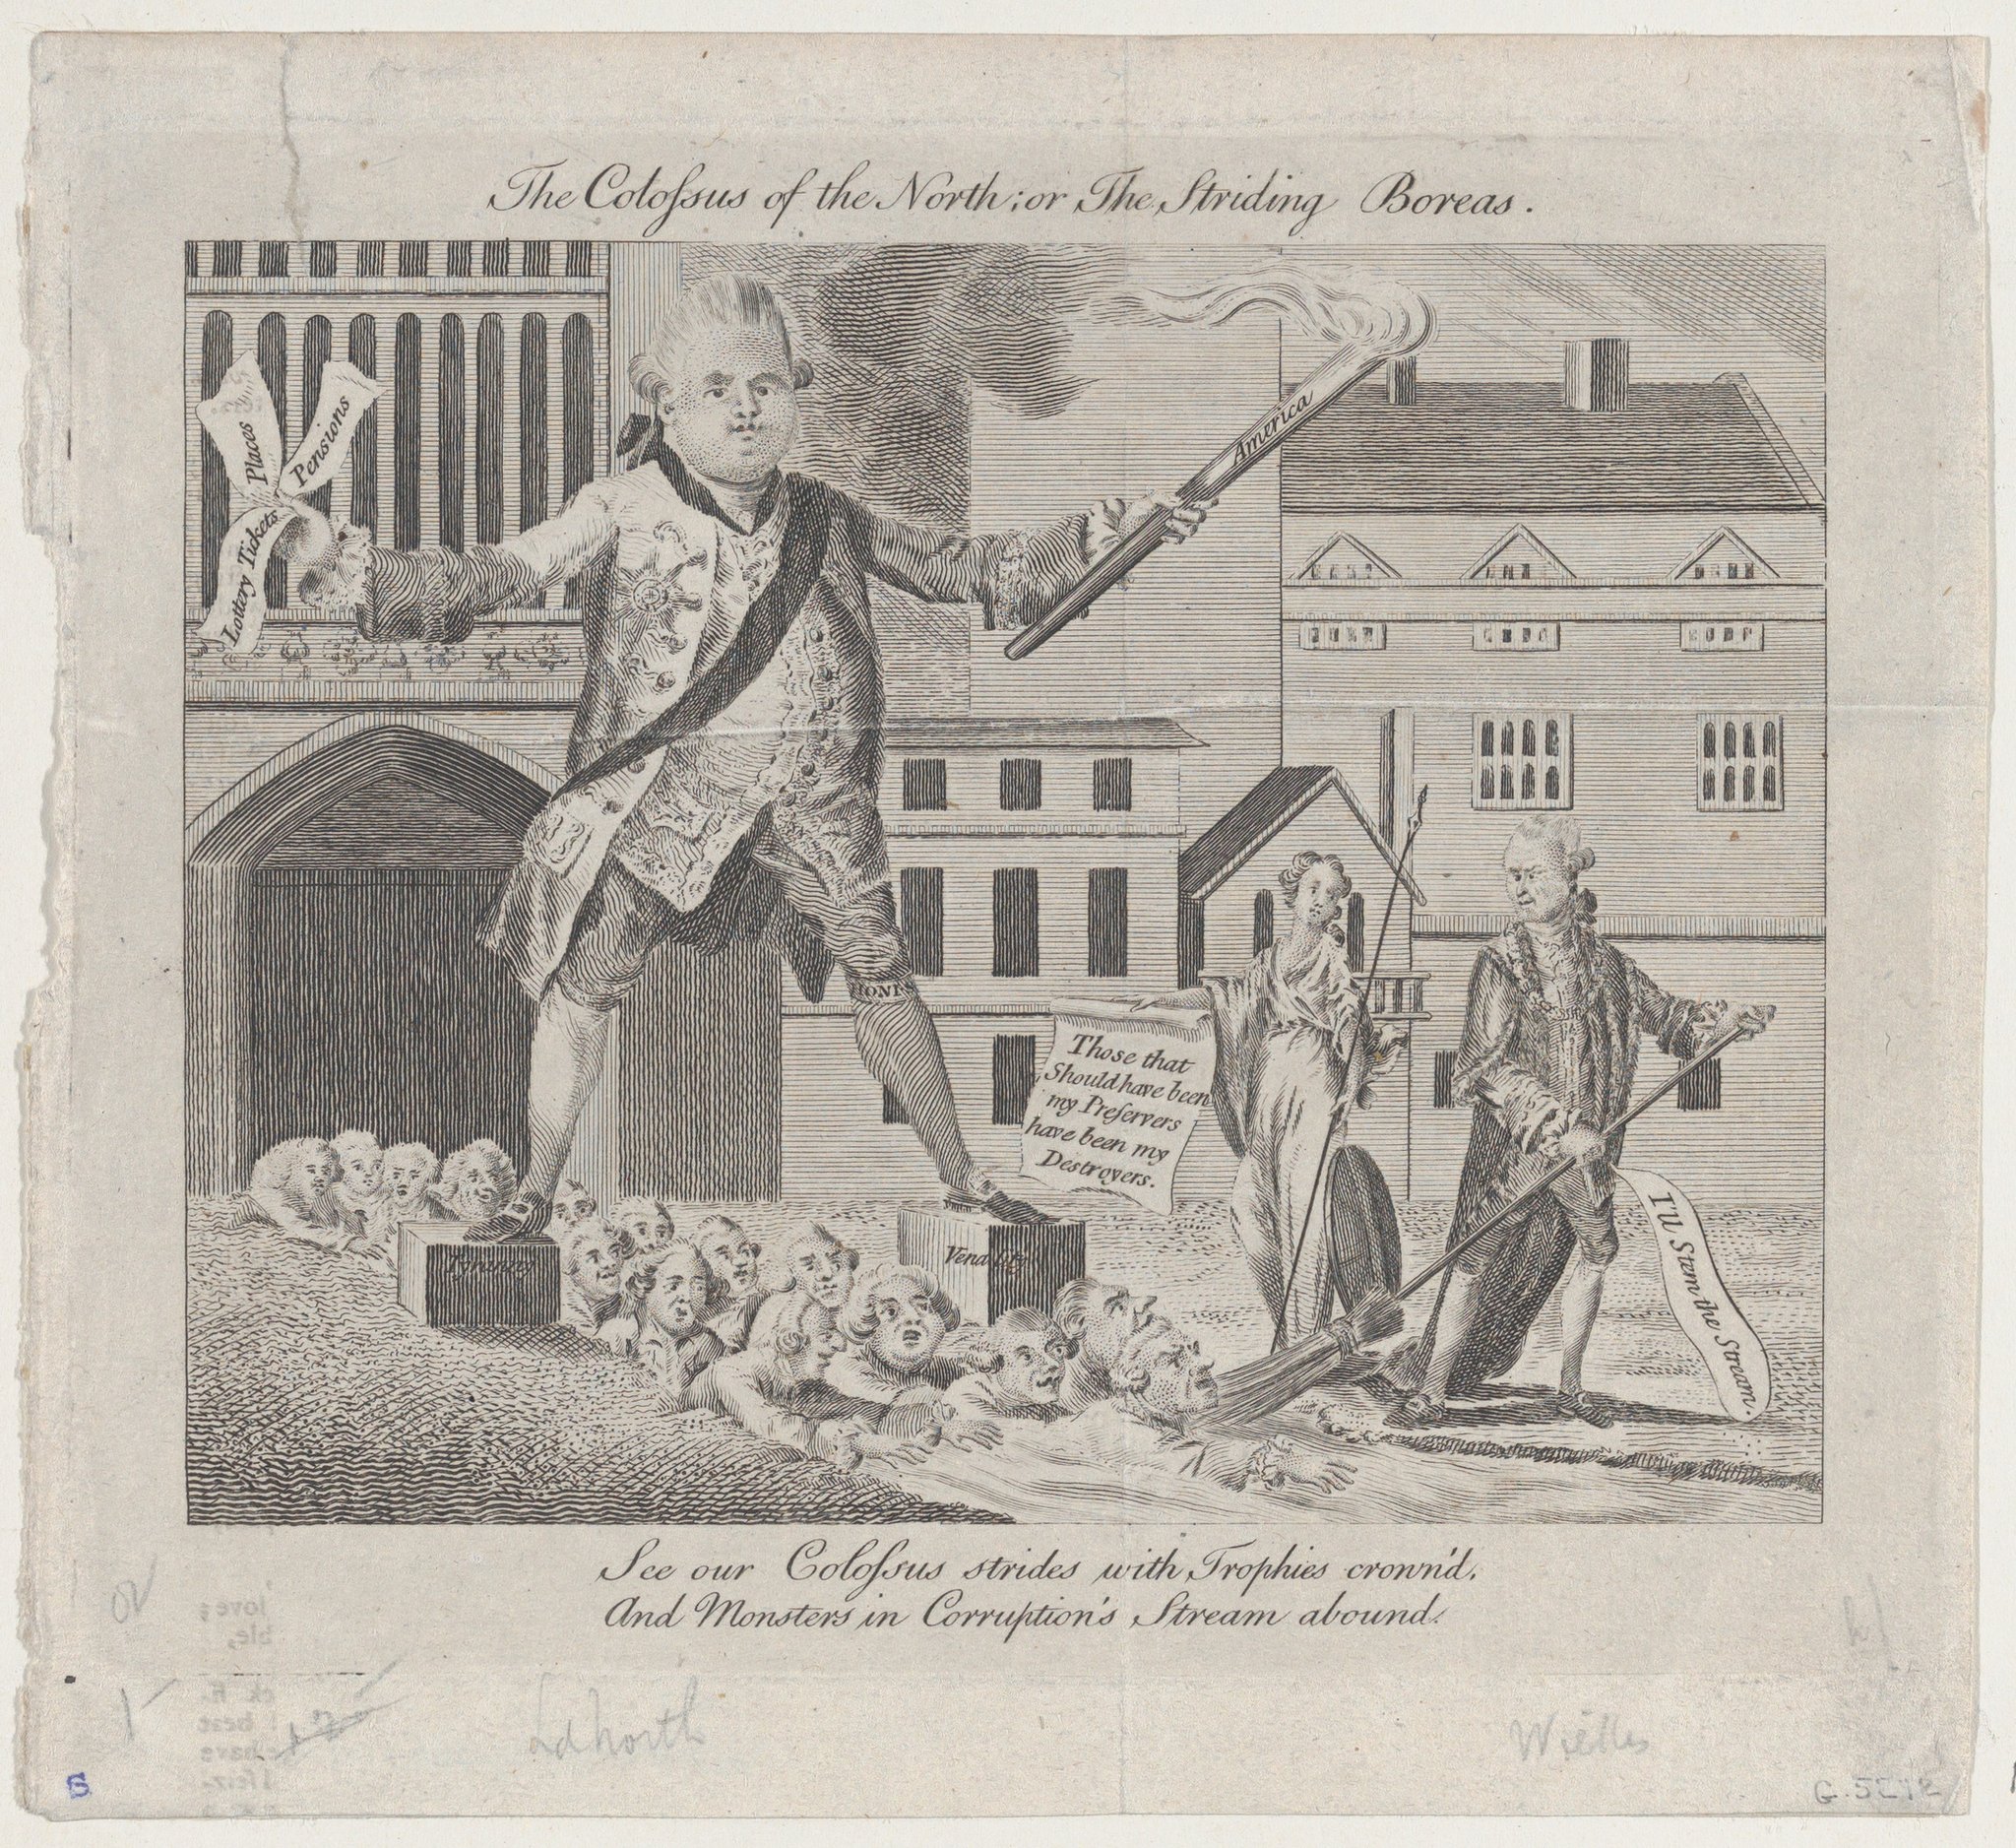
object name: print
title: The Colossus of the North; or the Striding Boreas, from The London Magazine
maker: anonymous, british, 18th century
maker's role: artist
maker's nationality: british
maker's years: 1700-1800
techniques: engraving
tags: satire,american revolution,men,politics